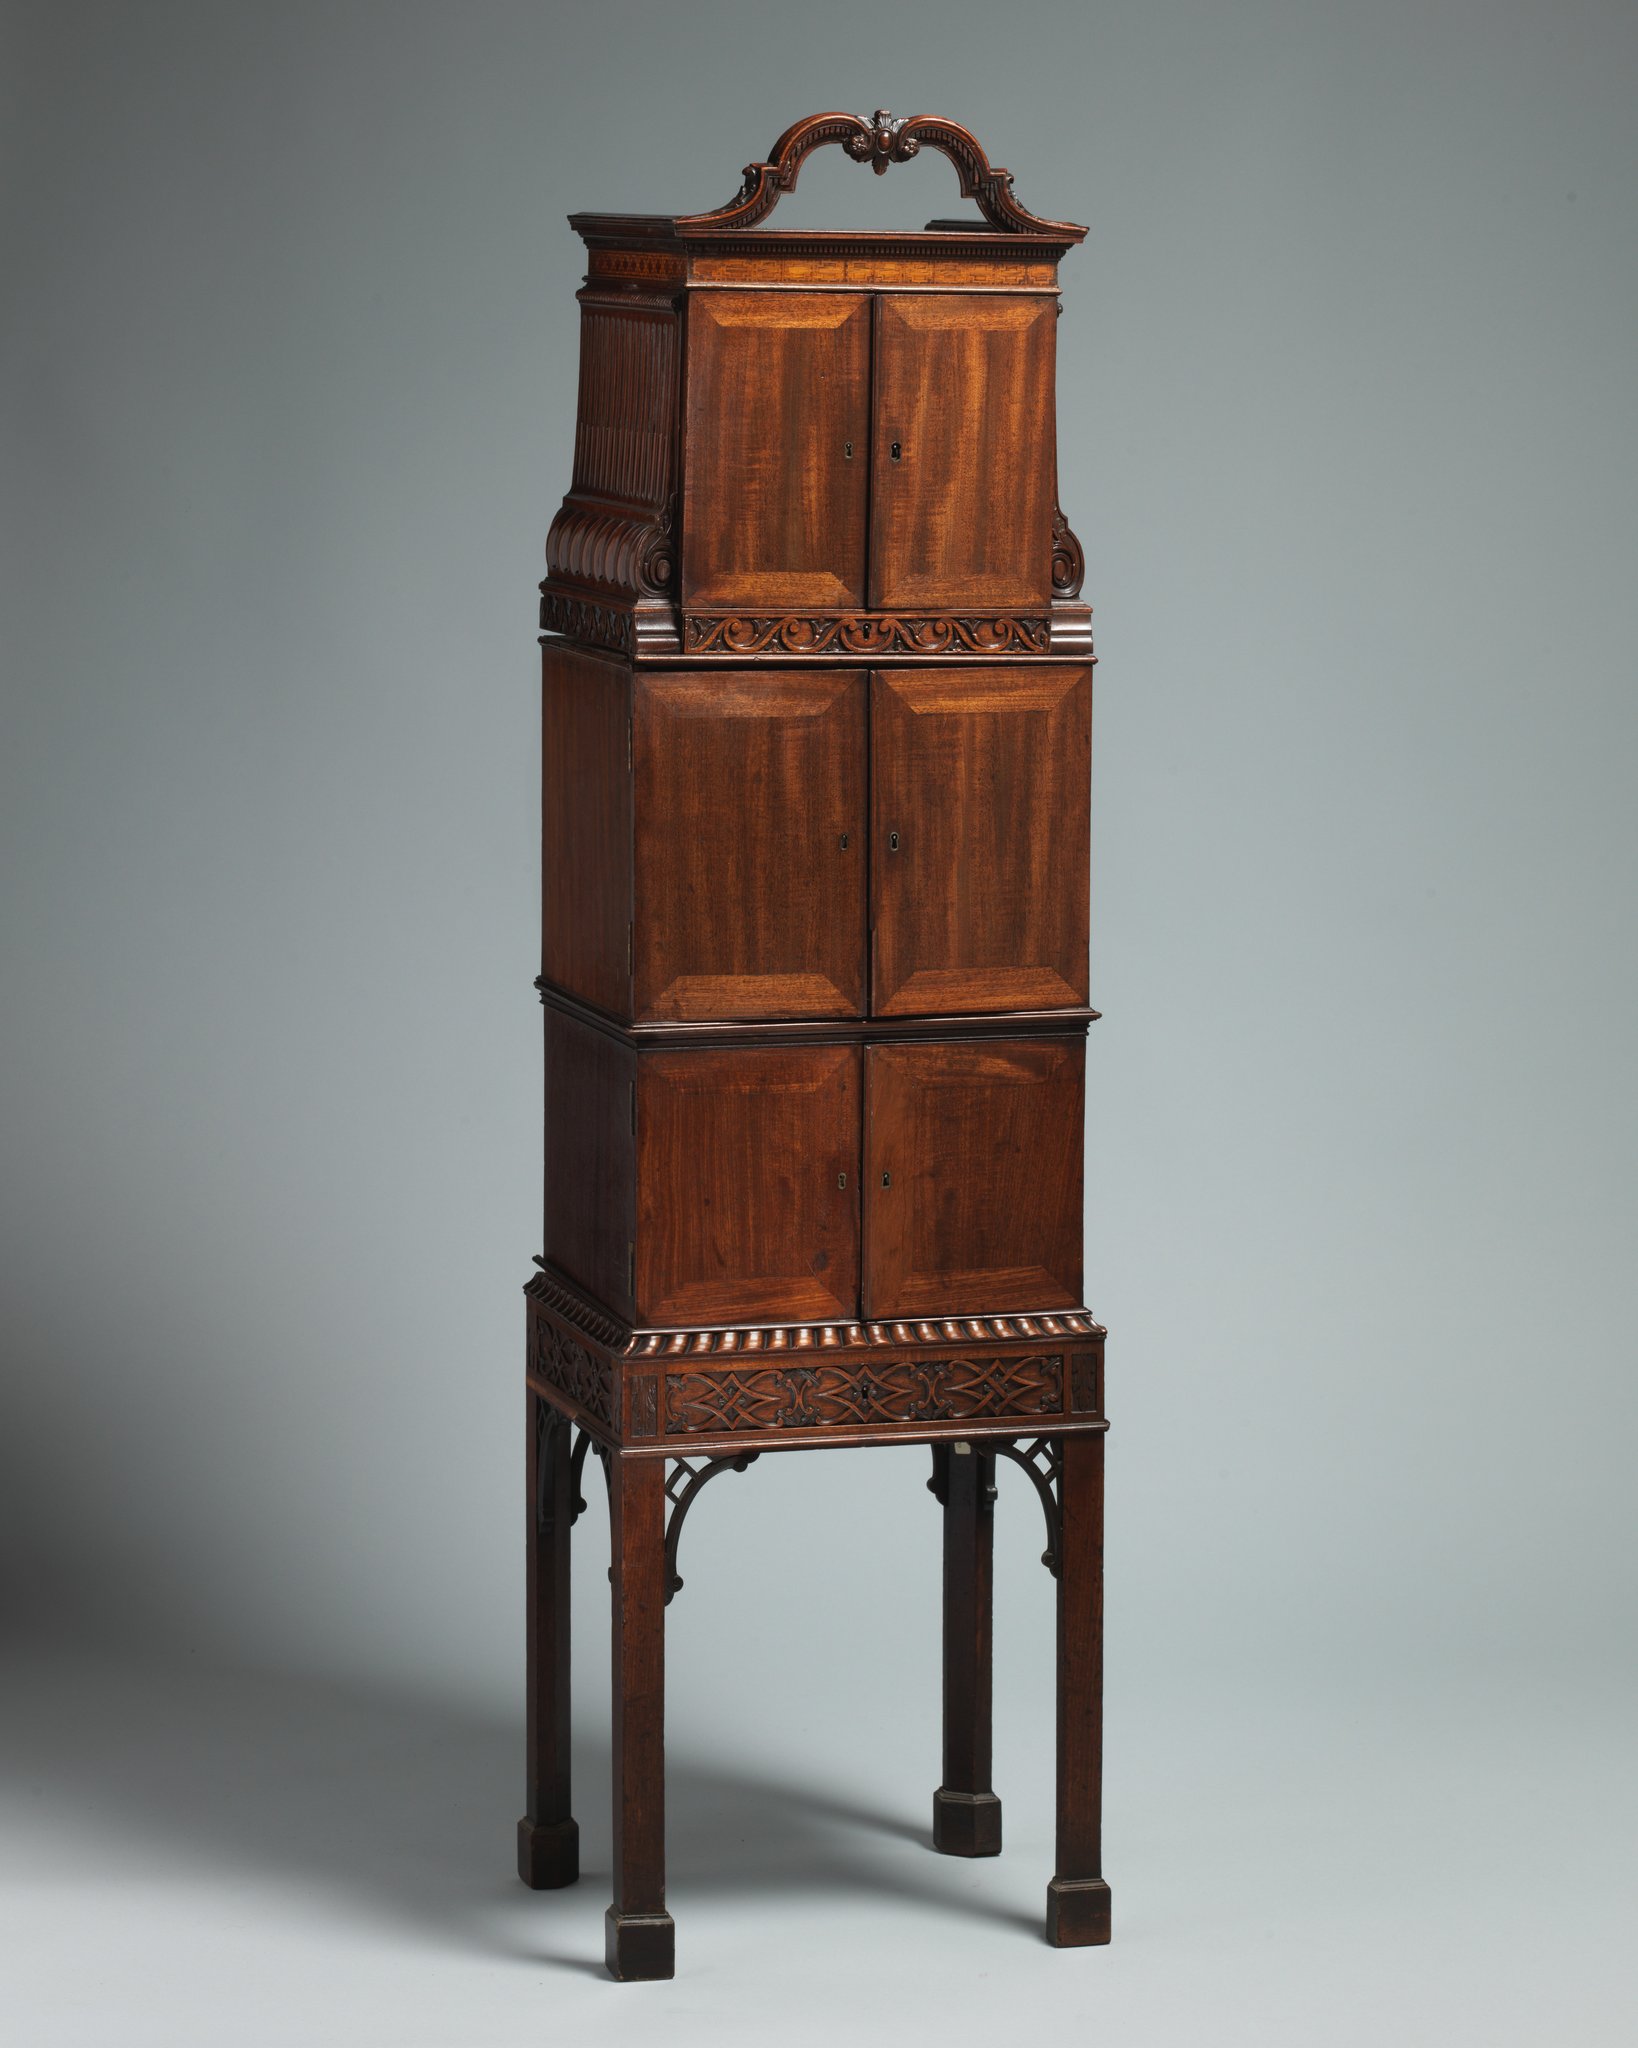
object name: coin cabinet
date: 1750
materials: wood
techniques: veneering